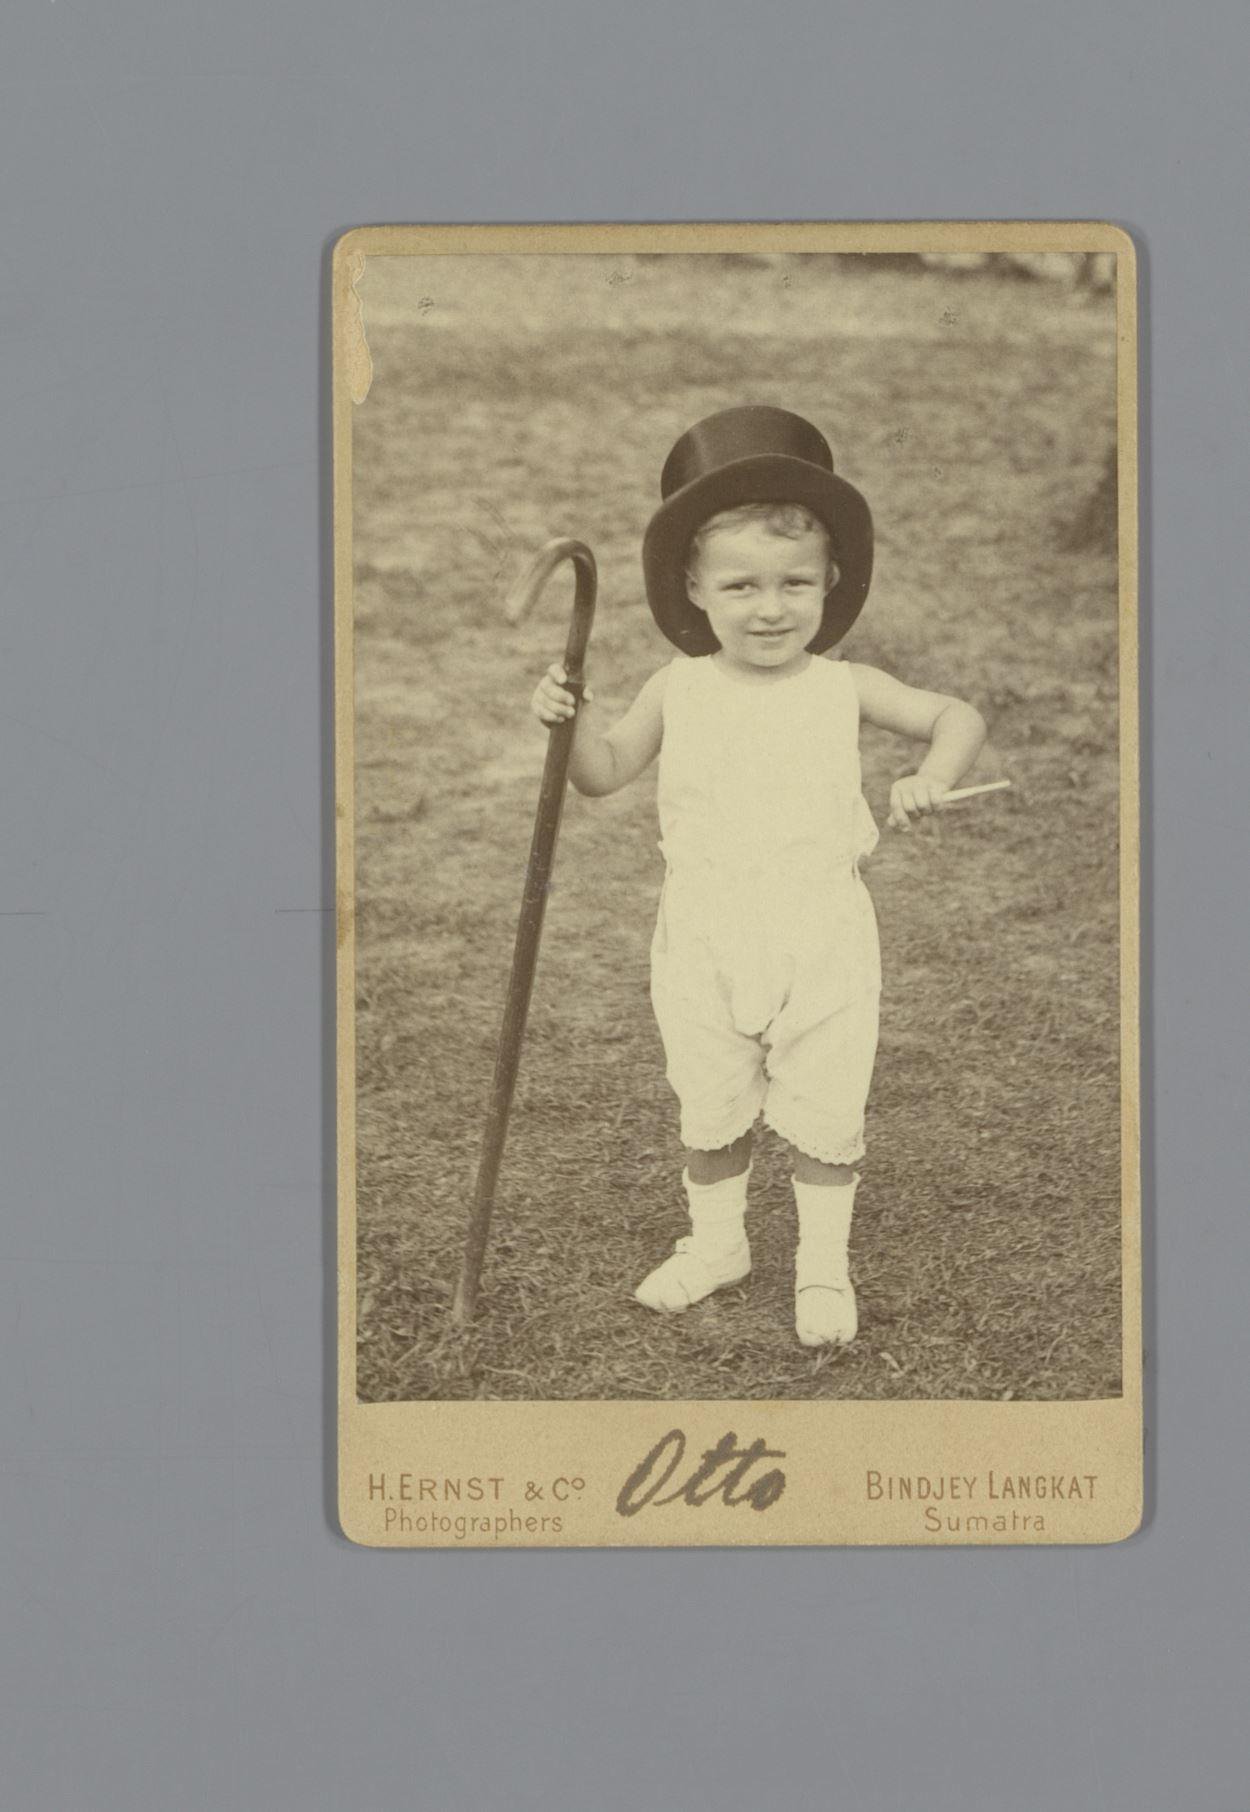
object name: carte de visite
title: Portret van Otto Sandel met wandelstok en hoed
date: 1905-1907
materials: cardboard, paper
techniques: albumen print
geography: bindjai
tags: toddler, walking-stick, staff, historical persons, head-gear: top hat, sumatra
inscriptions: inscription: ‘H. Ernst & Co./ Photographers/ Bindjey Langkat/ Sumatra./ Haake & Albers, Frankfort o/M.’, inscription: ‘H. Ernst & Co./ Photographers/ Bindjey Langkat/ Sumatra’, inscription: ‘Otto’, inscription: ‘2 Jakra/ dengan djelaka/ monjet/ Juli 1905./ Otto Sandel’